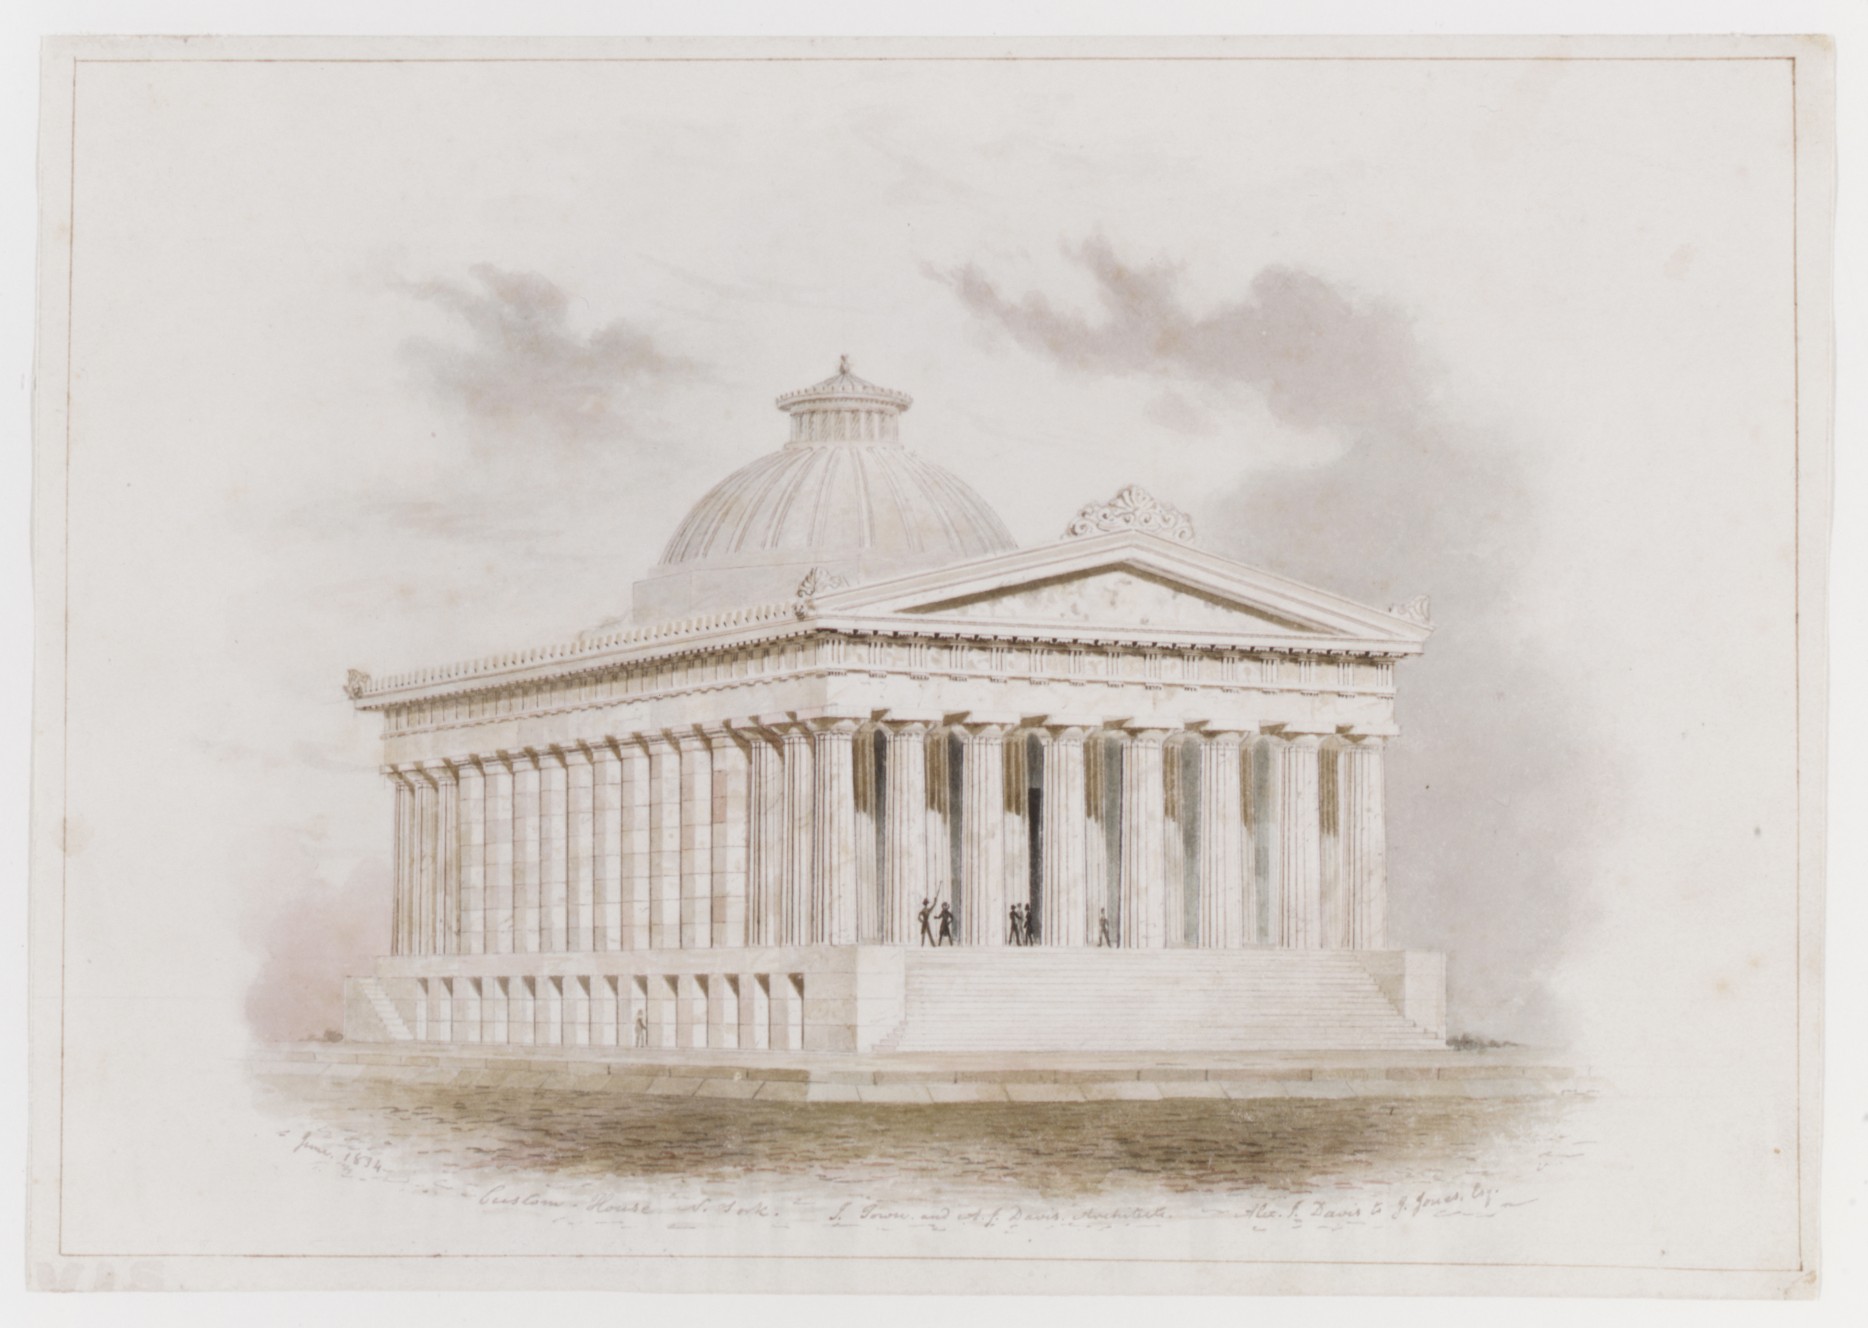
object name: drawing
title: U. S. Custom House, New York (perspective)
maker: ithiel town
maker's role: artist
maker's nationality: american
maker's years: 1784-1844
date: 1834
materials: graphite, watercolor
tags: buildings